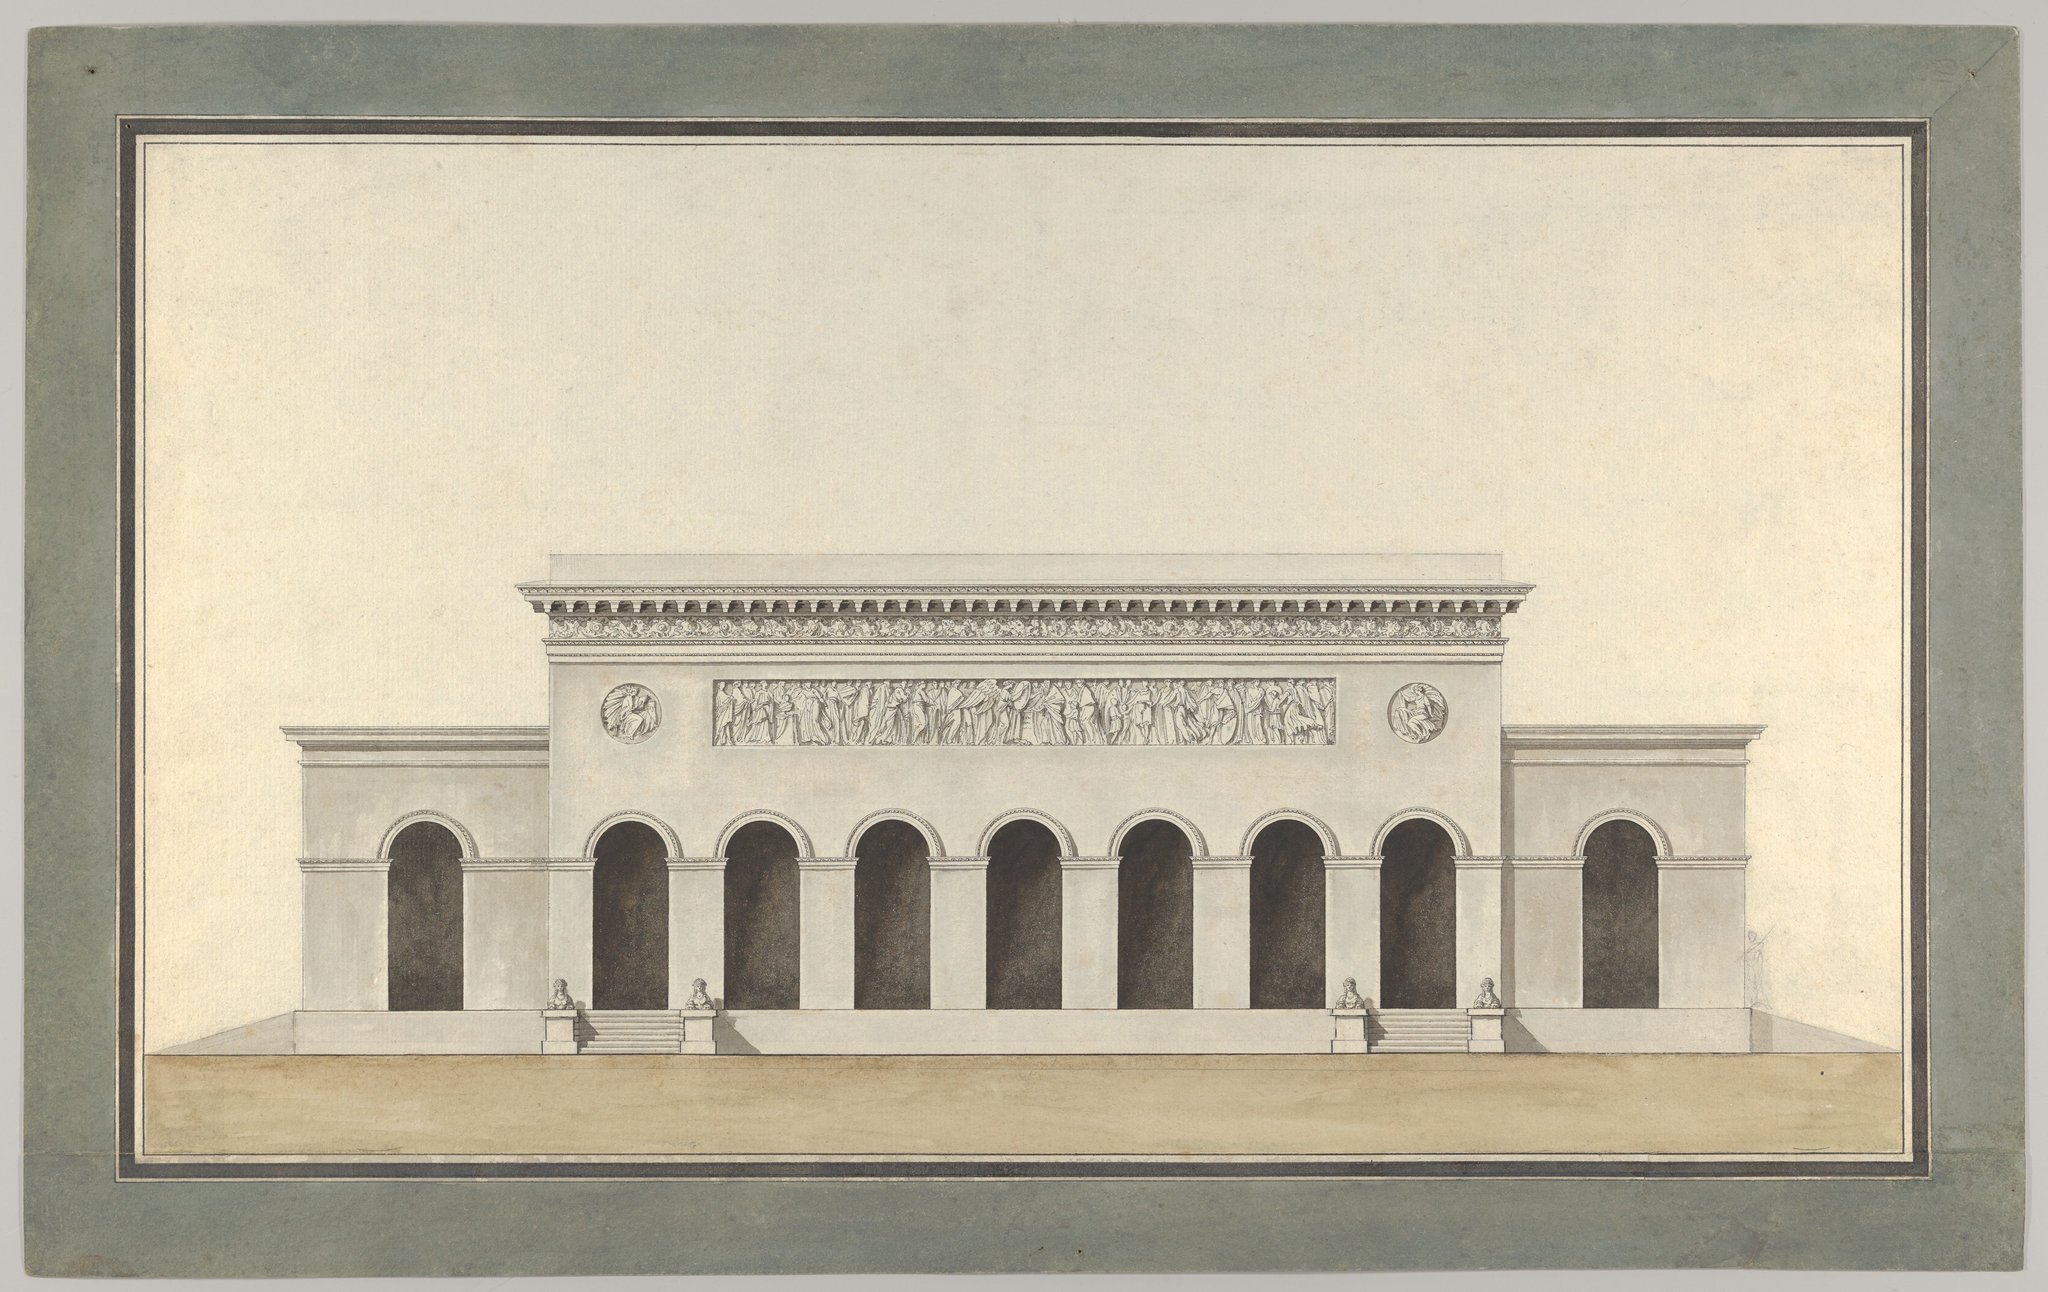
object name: drawing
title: Project for a Public Monument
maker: alexandre théodore brongniart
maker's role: artist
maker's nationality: french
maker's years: 1739-1813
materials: chalk, ink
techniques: pen, drawing, wash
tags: human figures,buildings